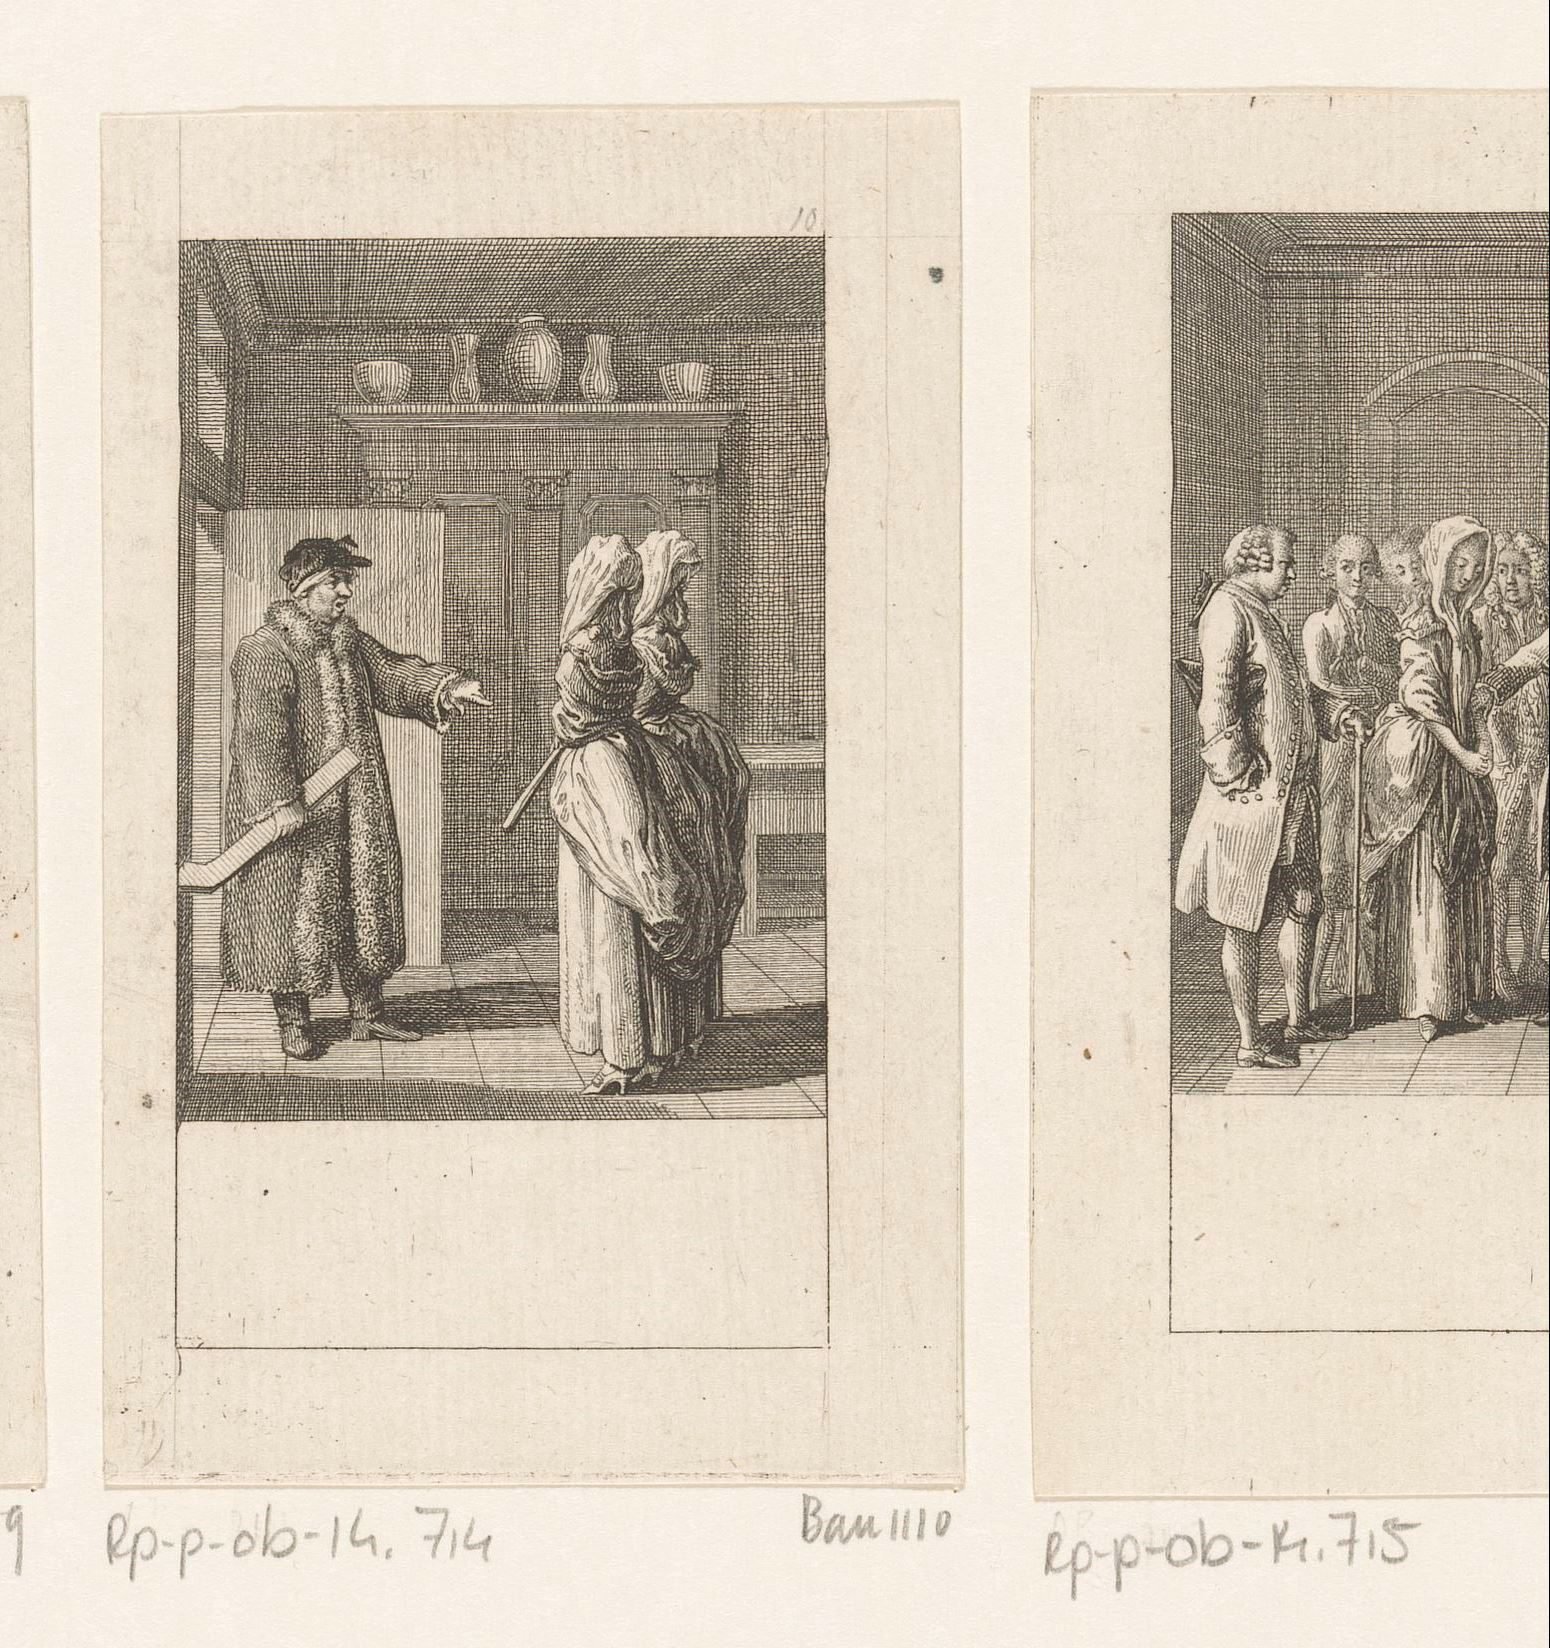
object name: print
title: Esch senior loopt zijn zus Olympia en nicht Charlotte tegen het lijf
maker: daniel nikolaus chodowiecki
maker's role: draughtsman, print maker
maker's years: 1726-1801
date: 1784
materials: paper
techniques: etching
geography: berlin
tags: literature, family, relationship, descent, index finger forwards, pointing, indicating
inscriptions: collector's mark: Lugt 2228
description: Vervaardigd voor Christian Friedrich Bretzners 'Eheprocurator'. Latere staat gebruikt voor: Konigl. Grosbrit. Genealogischen Kalender auf das Jahr 1785. Lauenburg: J. G. Berenberg, 1784.